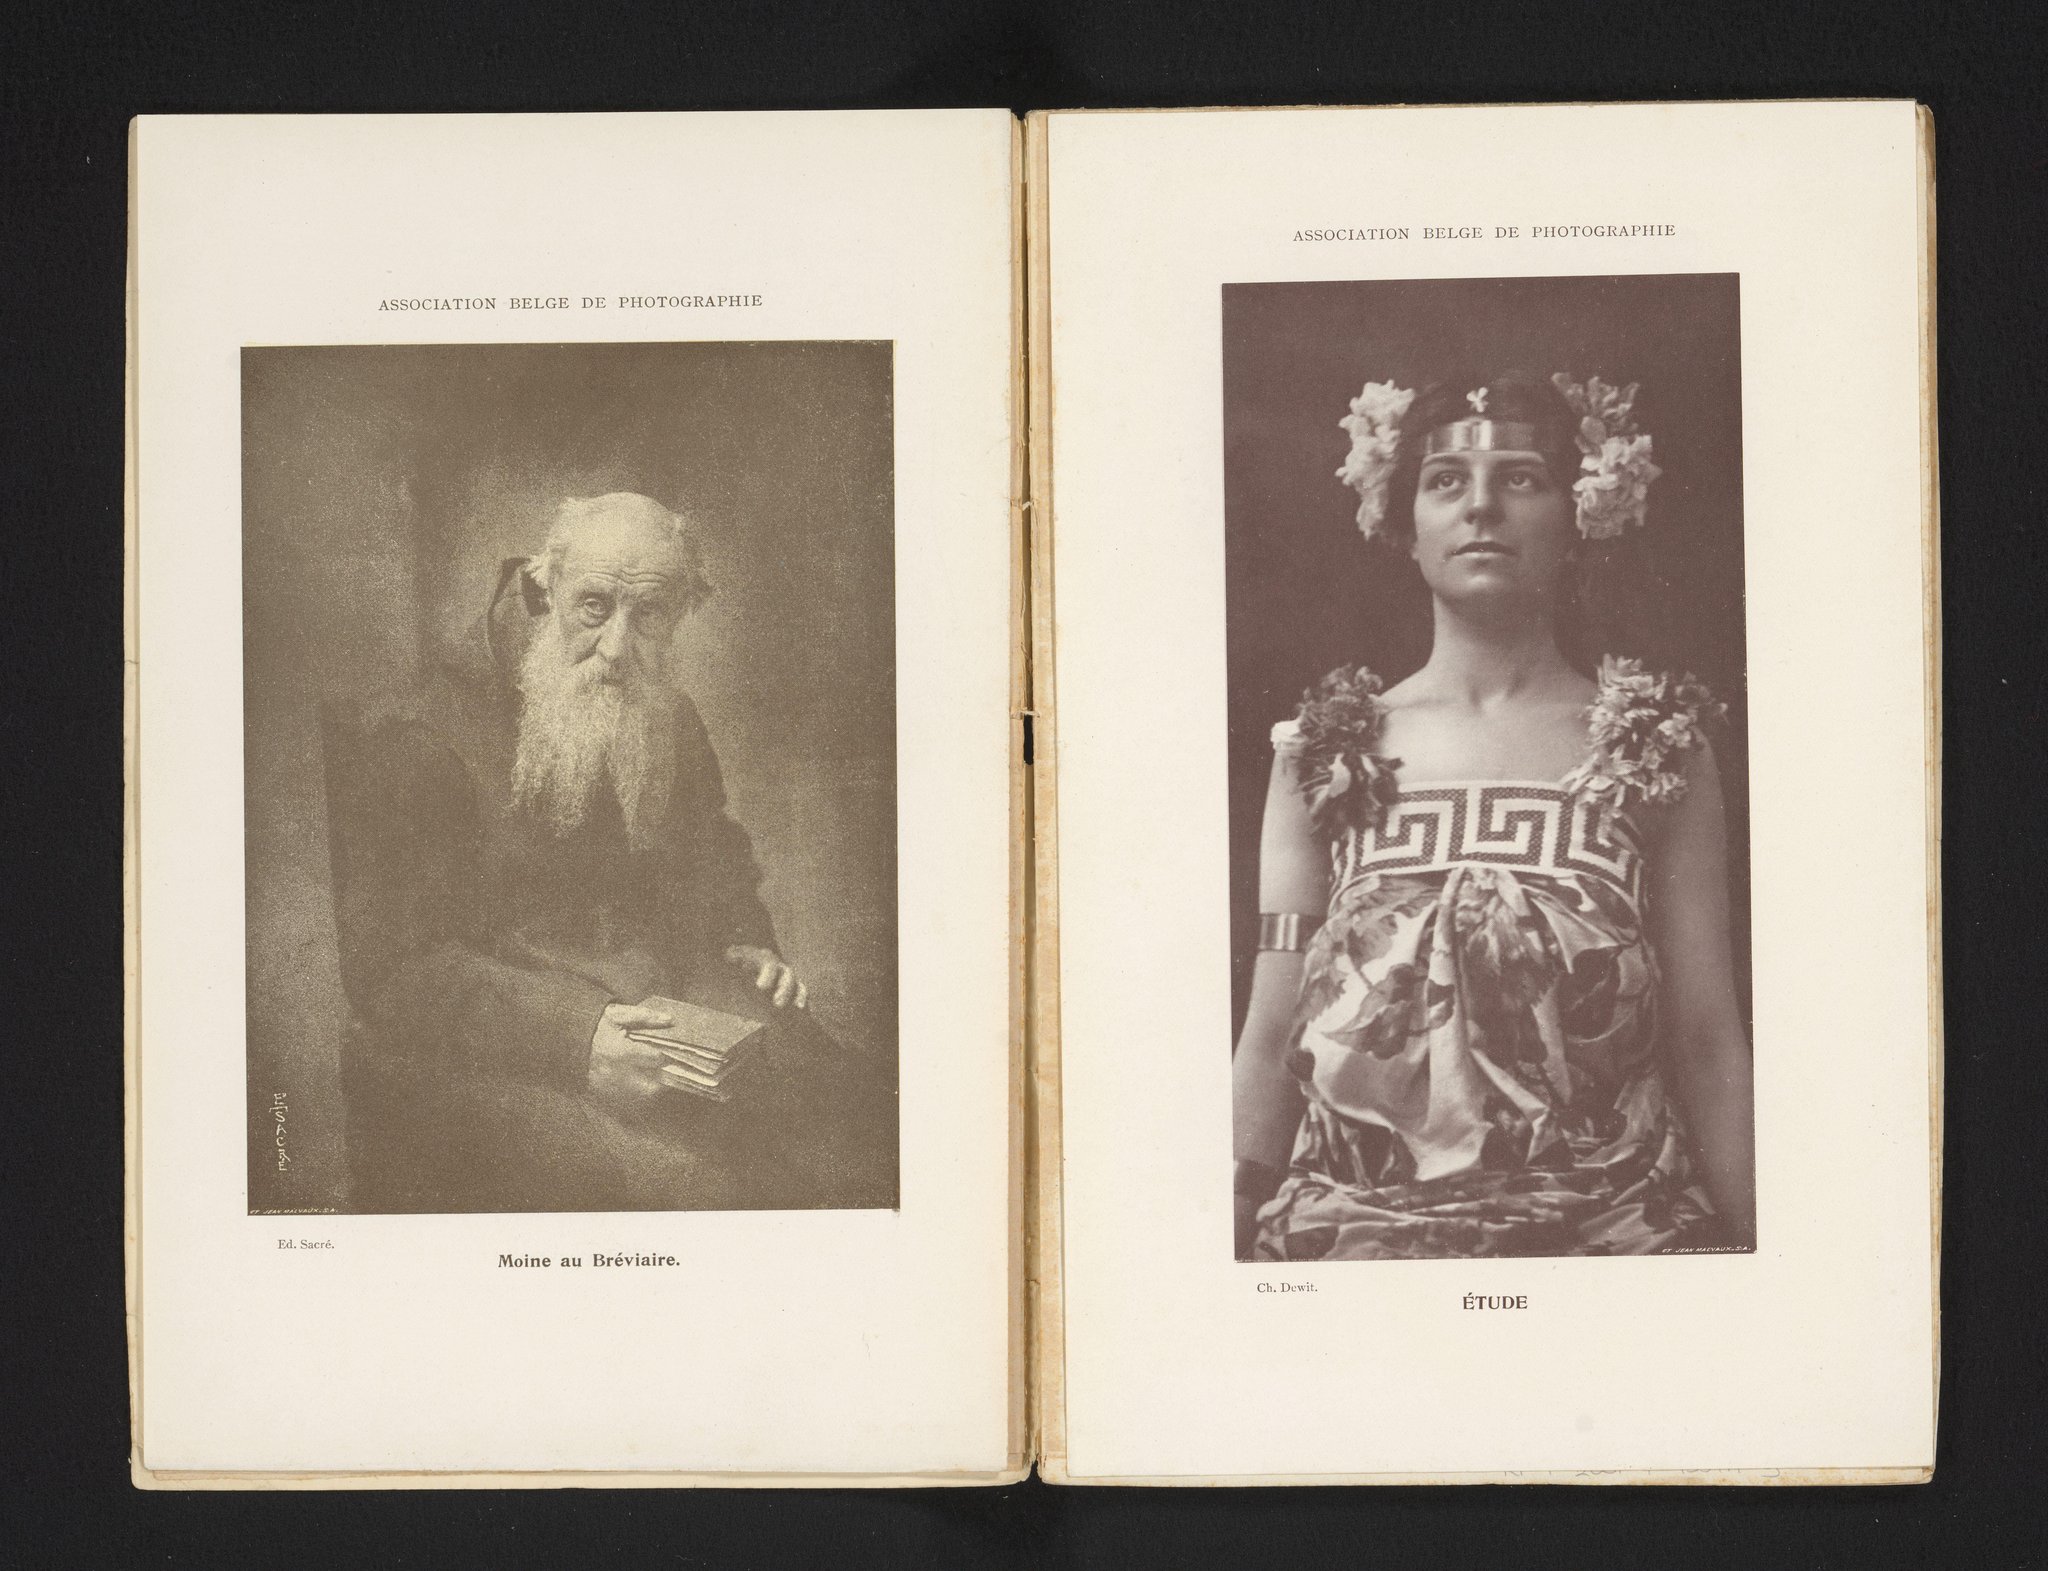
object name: photomechanical print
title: Portret van een onbekende oude man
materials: paper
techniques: autotype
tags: old man, historical persons not known by name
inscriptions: inscription: ‘ASSOCIATION BELGE DE PHOTOGRAPHIE’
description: Prent op plaat los in boek tussen pagina XVI en 587.